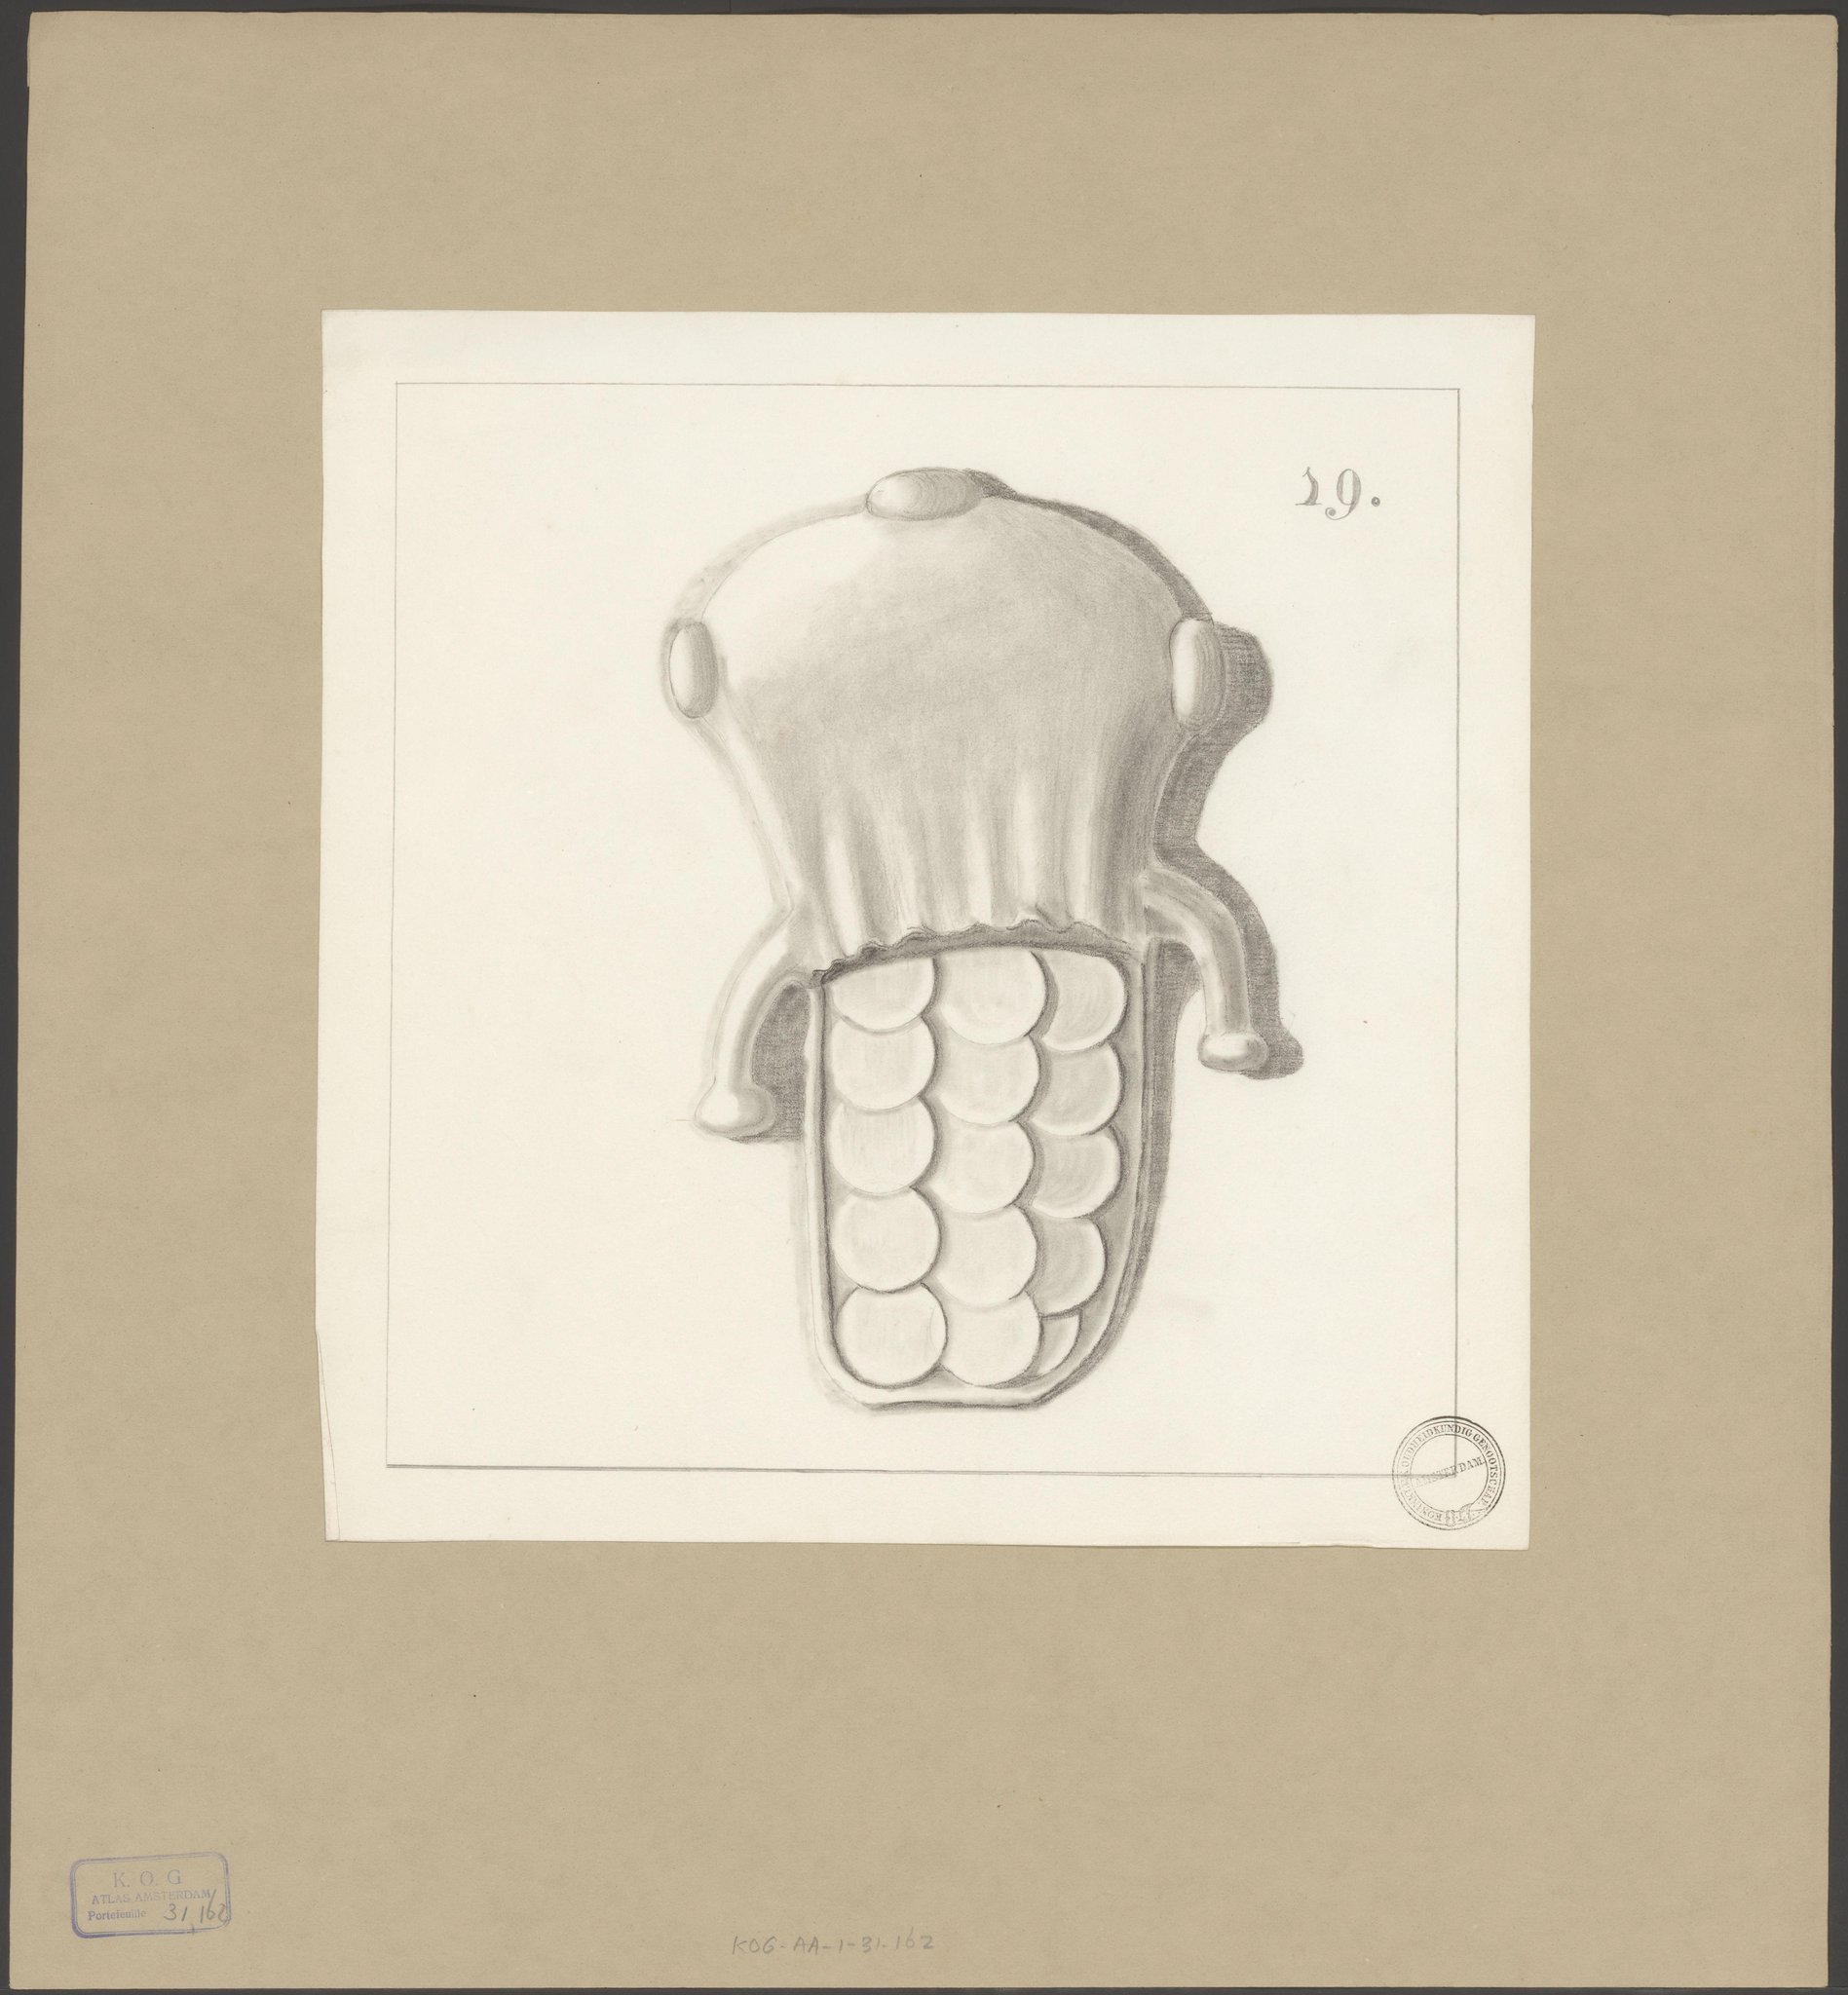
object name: print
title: Misericorde met omgekeerde beurs met geld in de Oude Kerk te Amsterdam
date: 1880-1929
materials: paper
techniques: lithograph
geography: amsterdam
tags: purse, money-bag, misericords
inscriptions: collector's mark: ‘31,162’ Lugt 1641b, collector's mark: ‘Koninklijk Oudheidkundig Genootschap / Amsterdam’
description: Rechtsboven genummerd: 19. Onderwerpsrubriek binnen de Atlas Amsterdam: Kerkwezen: Hervormde Gemeente: Oude Kerk, koorgestoelte.